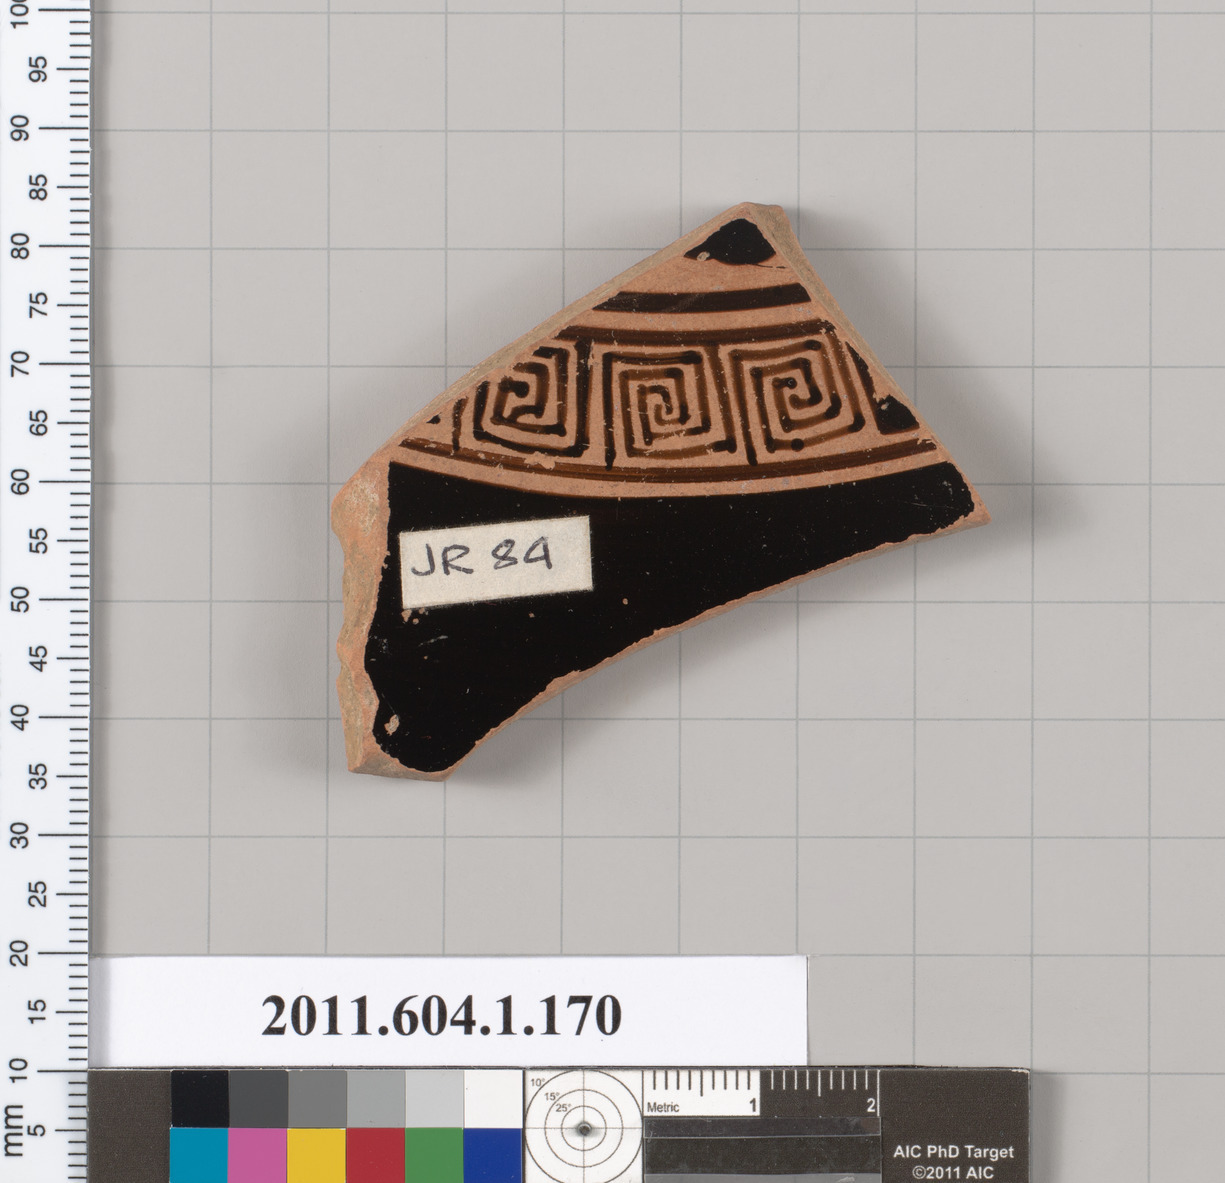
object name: kylix fragment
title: Terracotta fragment of a kylix (drinking cup)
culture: greek, attic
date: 470-450 BCE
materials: terracotta